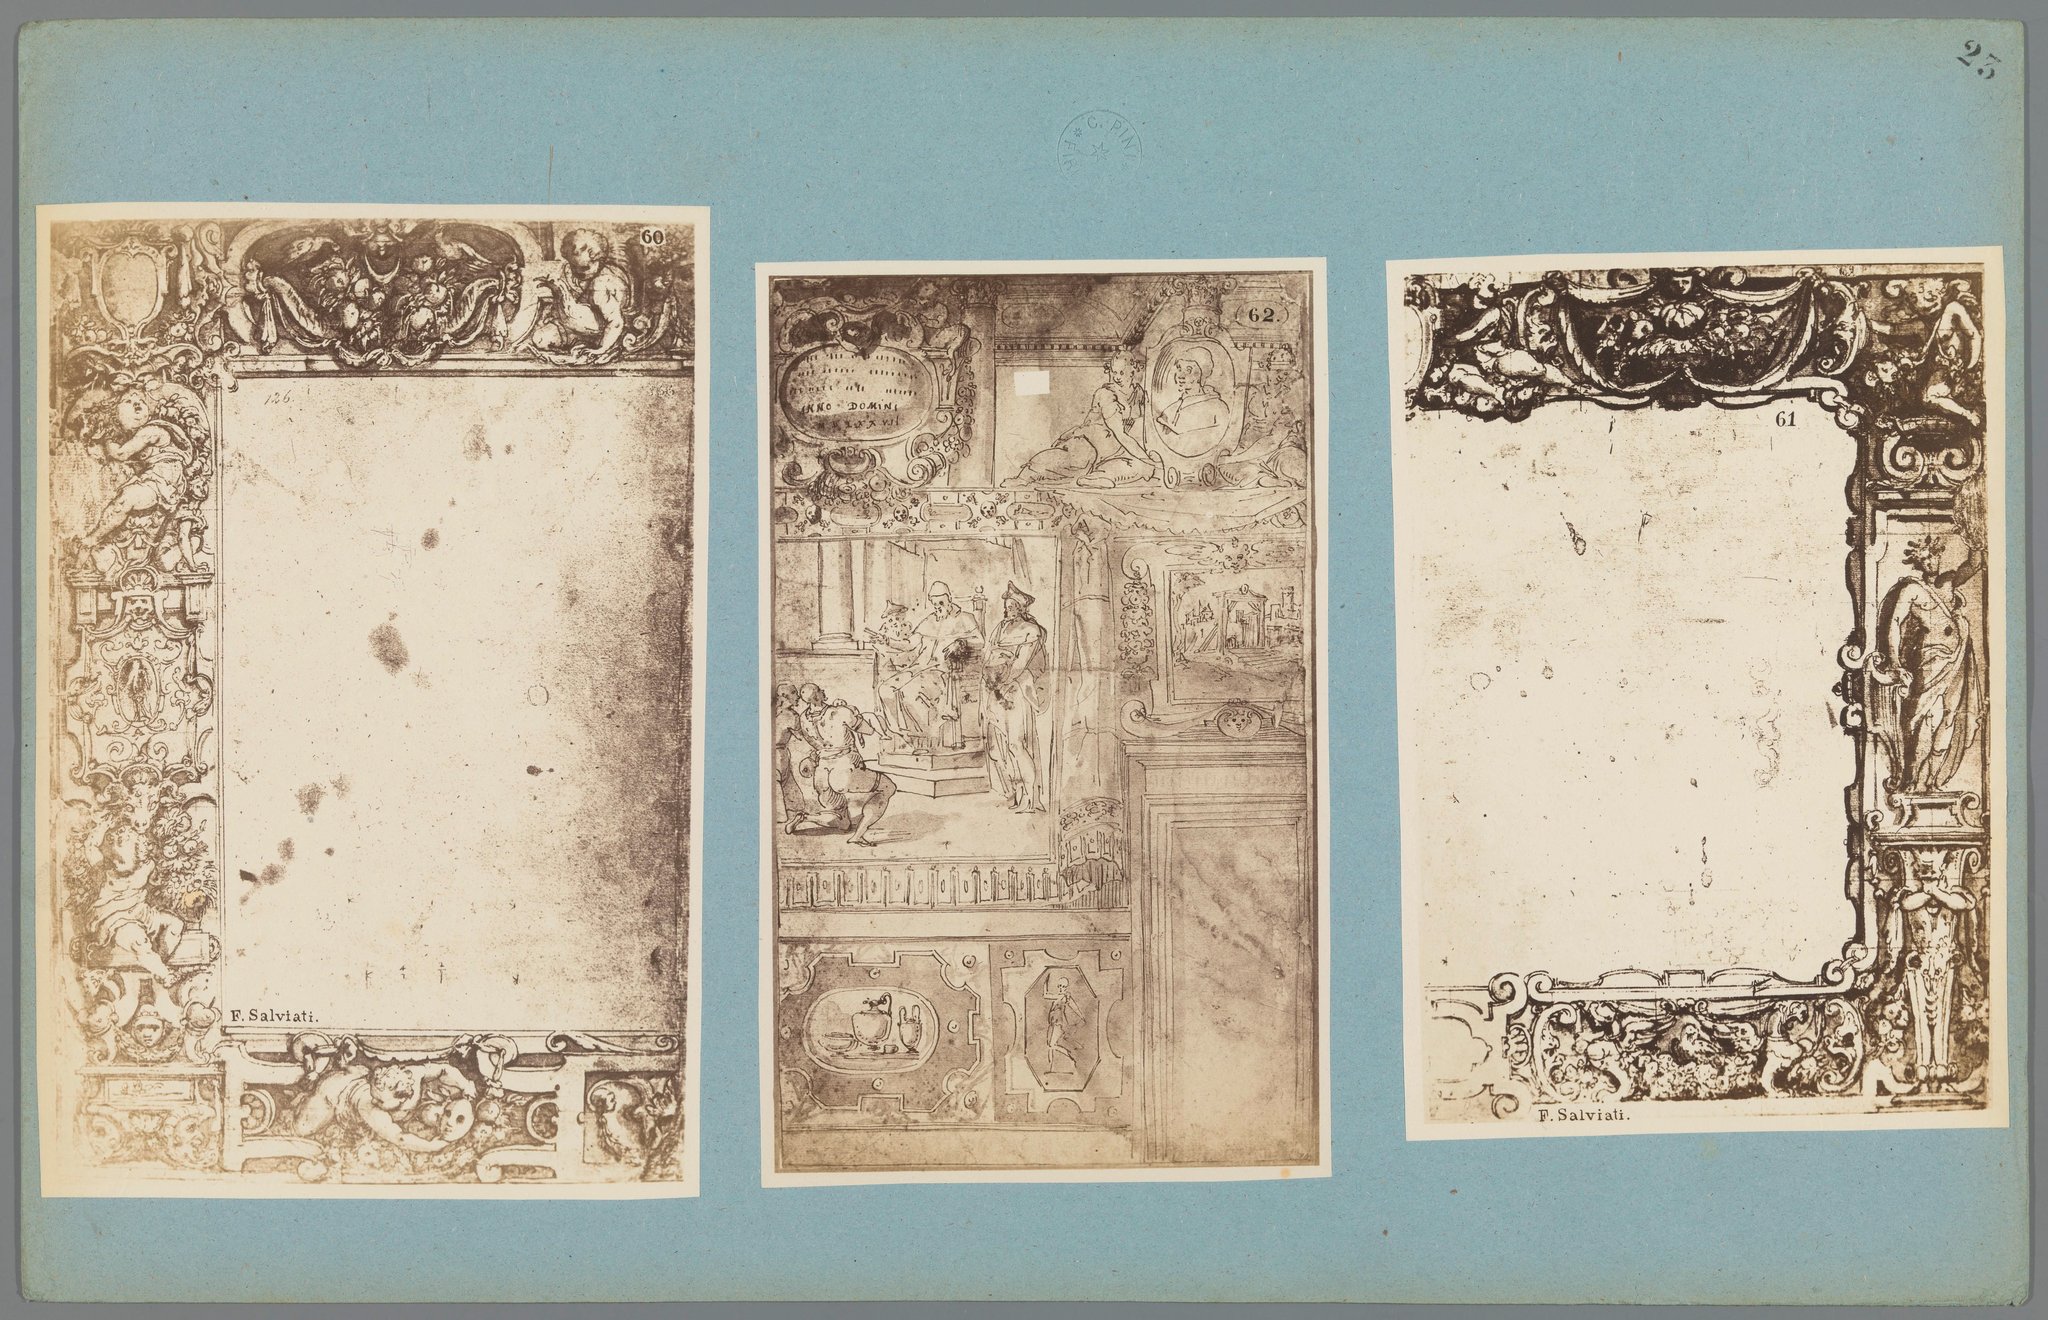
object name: photograph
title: Drie fotoreproducties van tekeningen van decoratieve vlakvullingen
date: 1875-1900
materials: cardboard, photographic support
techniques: albumen print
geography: europe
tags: fantasy ornament, fruits and vegetables ~ ornament, pope, cupids: 'amores', 'amoretti', 'putti', europe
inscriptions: name: ‘C. PINI FIRENZE’, number: ‘23’, collector's mark: Lugt 3937, number: ‘60’, number: ‘61’, number: ‘62.’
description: Links (60) een tekening van banddecoratie met fantasieornamenten, midden (62) een tekening van wanddecoratie met een voorstelling van een gezetelde paus en een portret, rechts (61) een tekening van banddecoratie met fantasieornamenten.